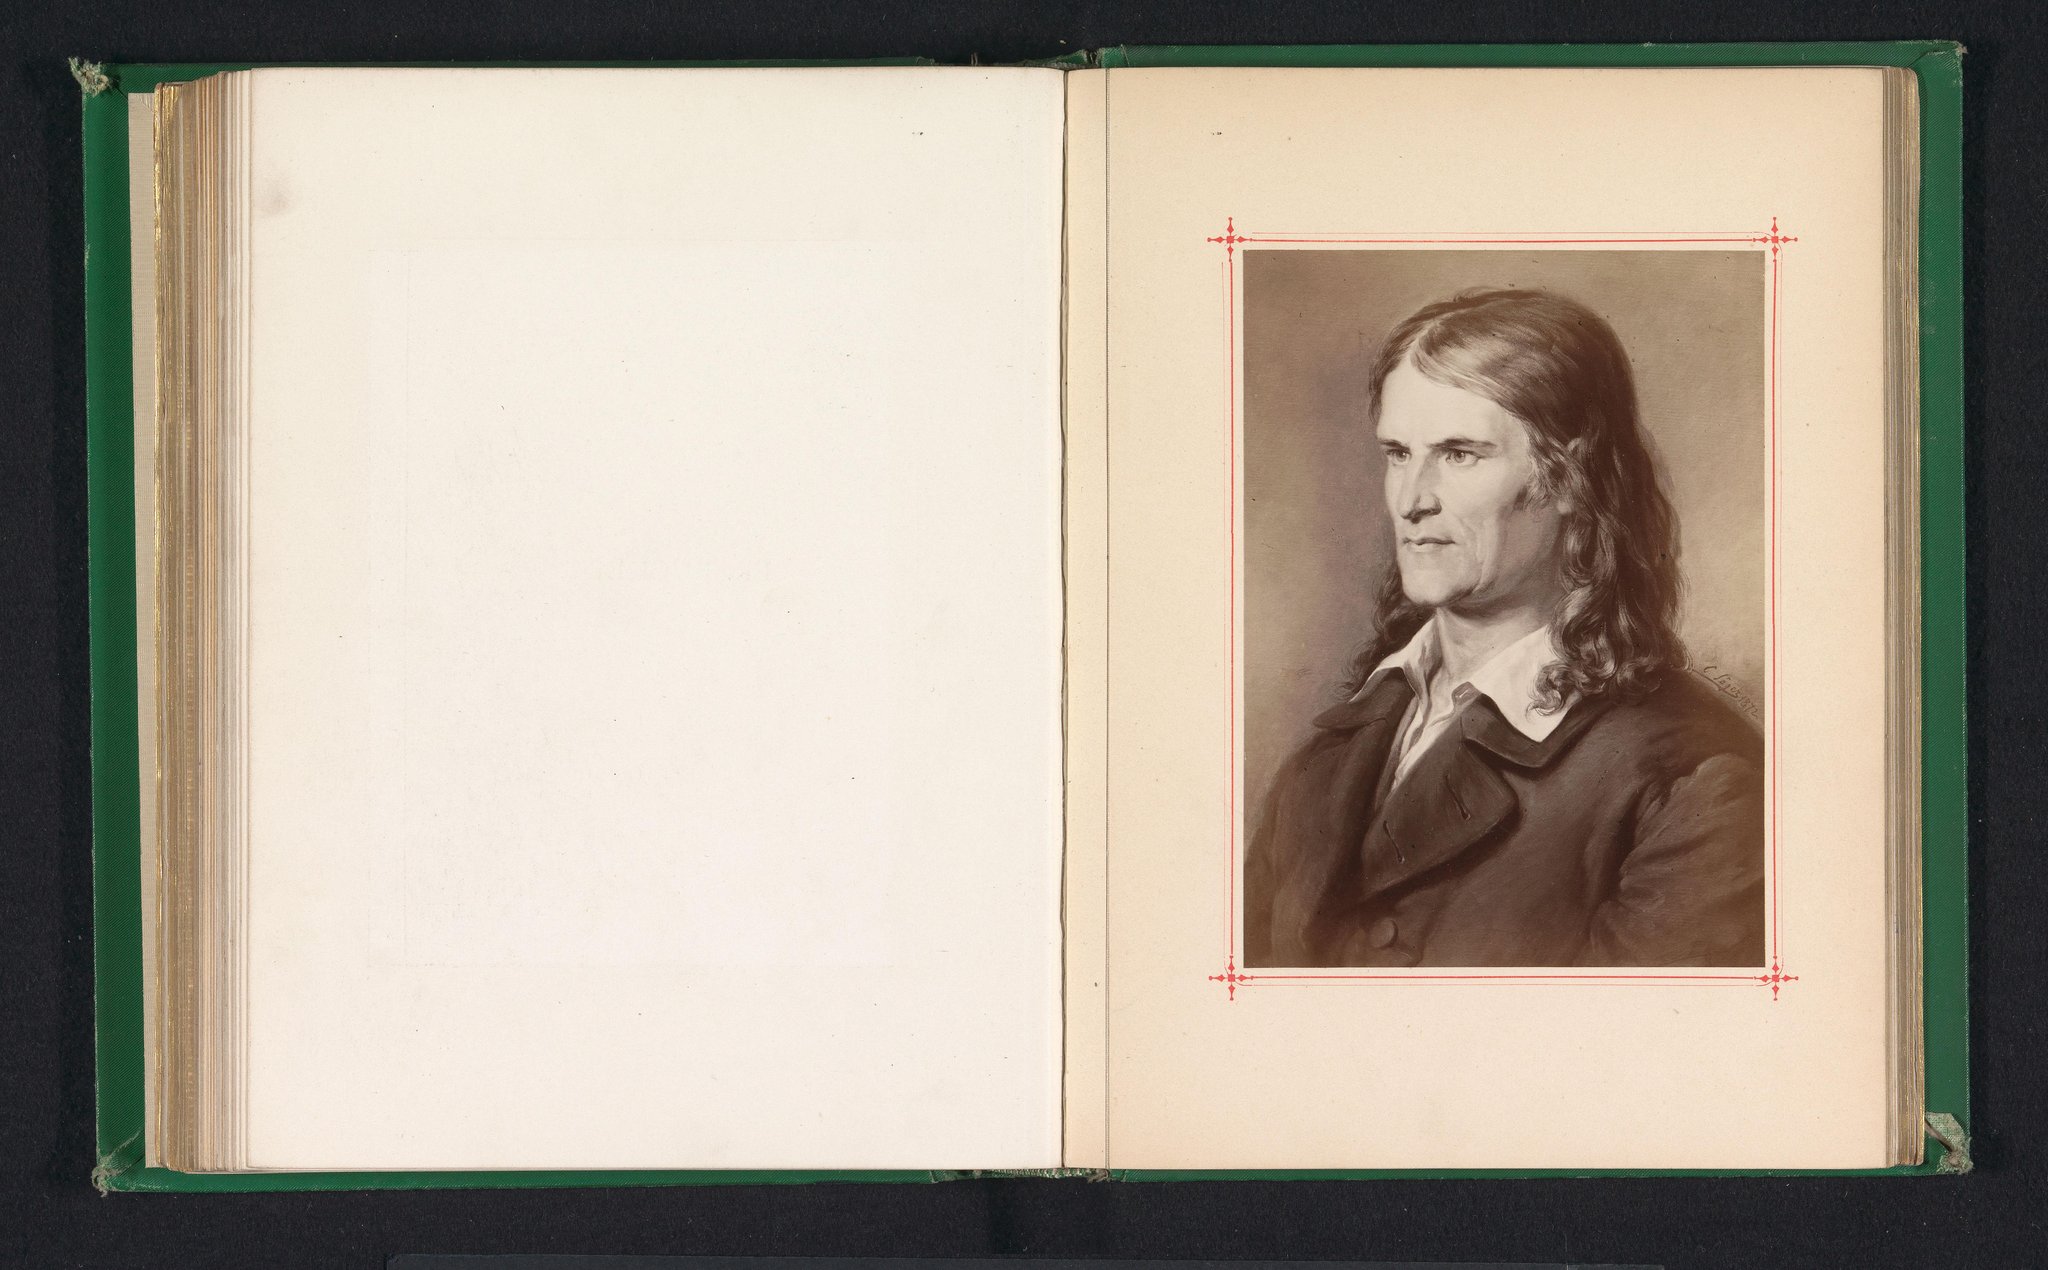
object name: reproduction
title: Fotoreproductie van een portret van Friedrich Rückert door Carl Jäger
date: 1868-1878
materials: photographic support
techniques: albumen print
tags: friedrich rückert, writer, poet, author